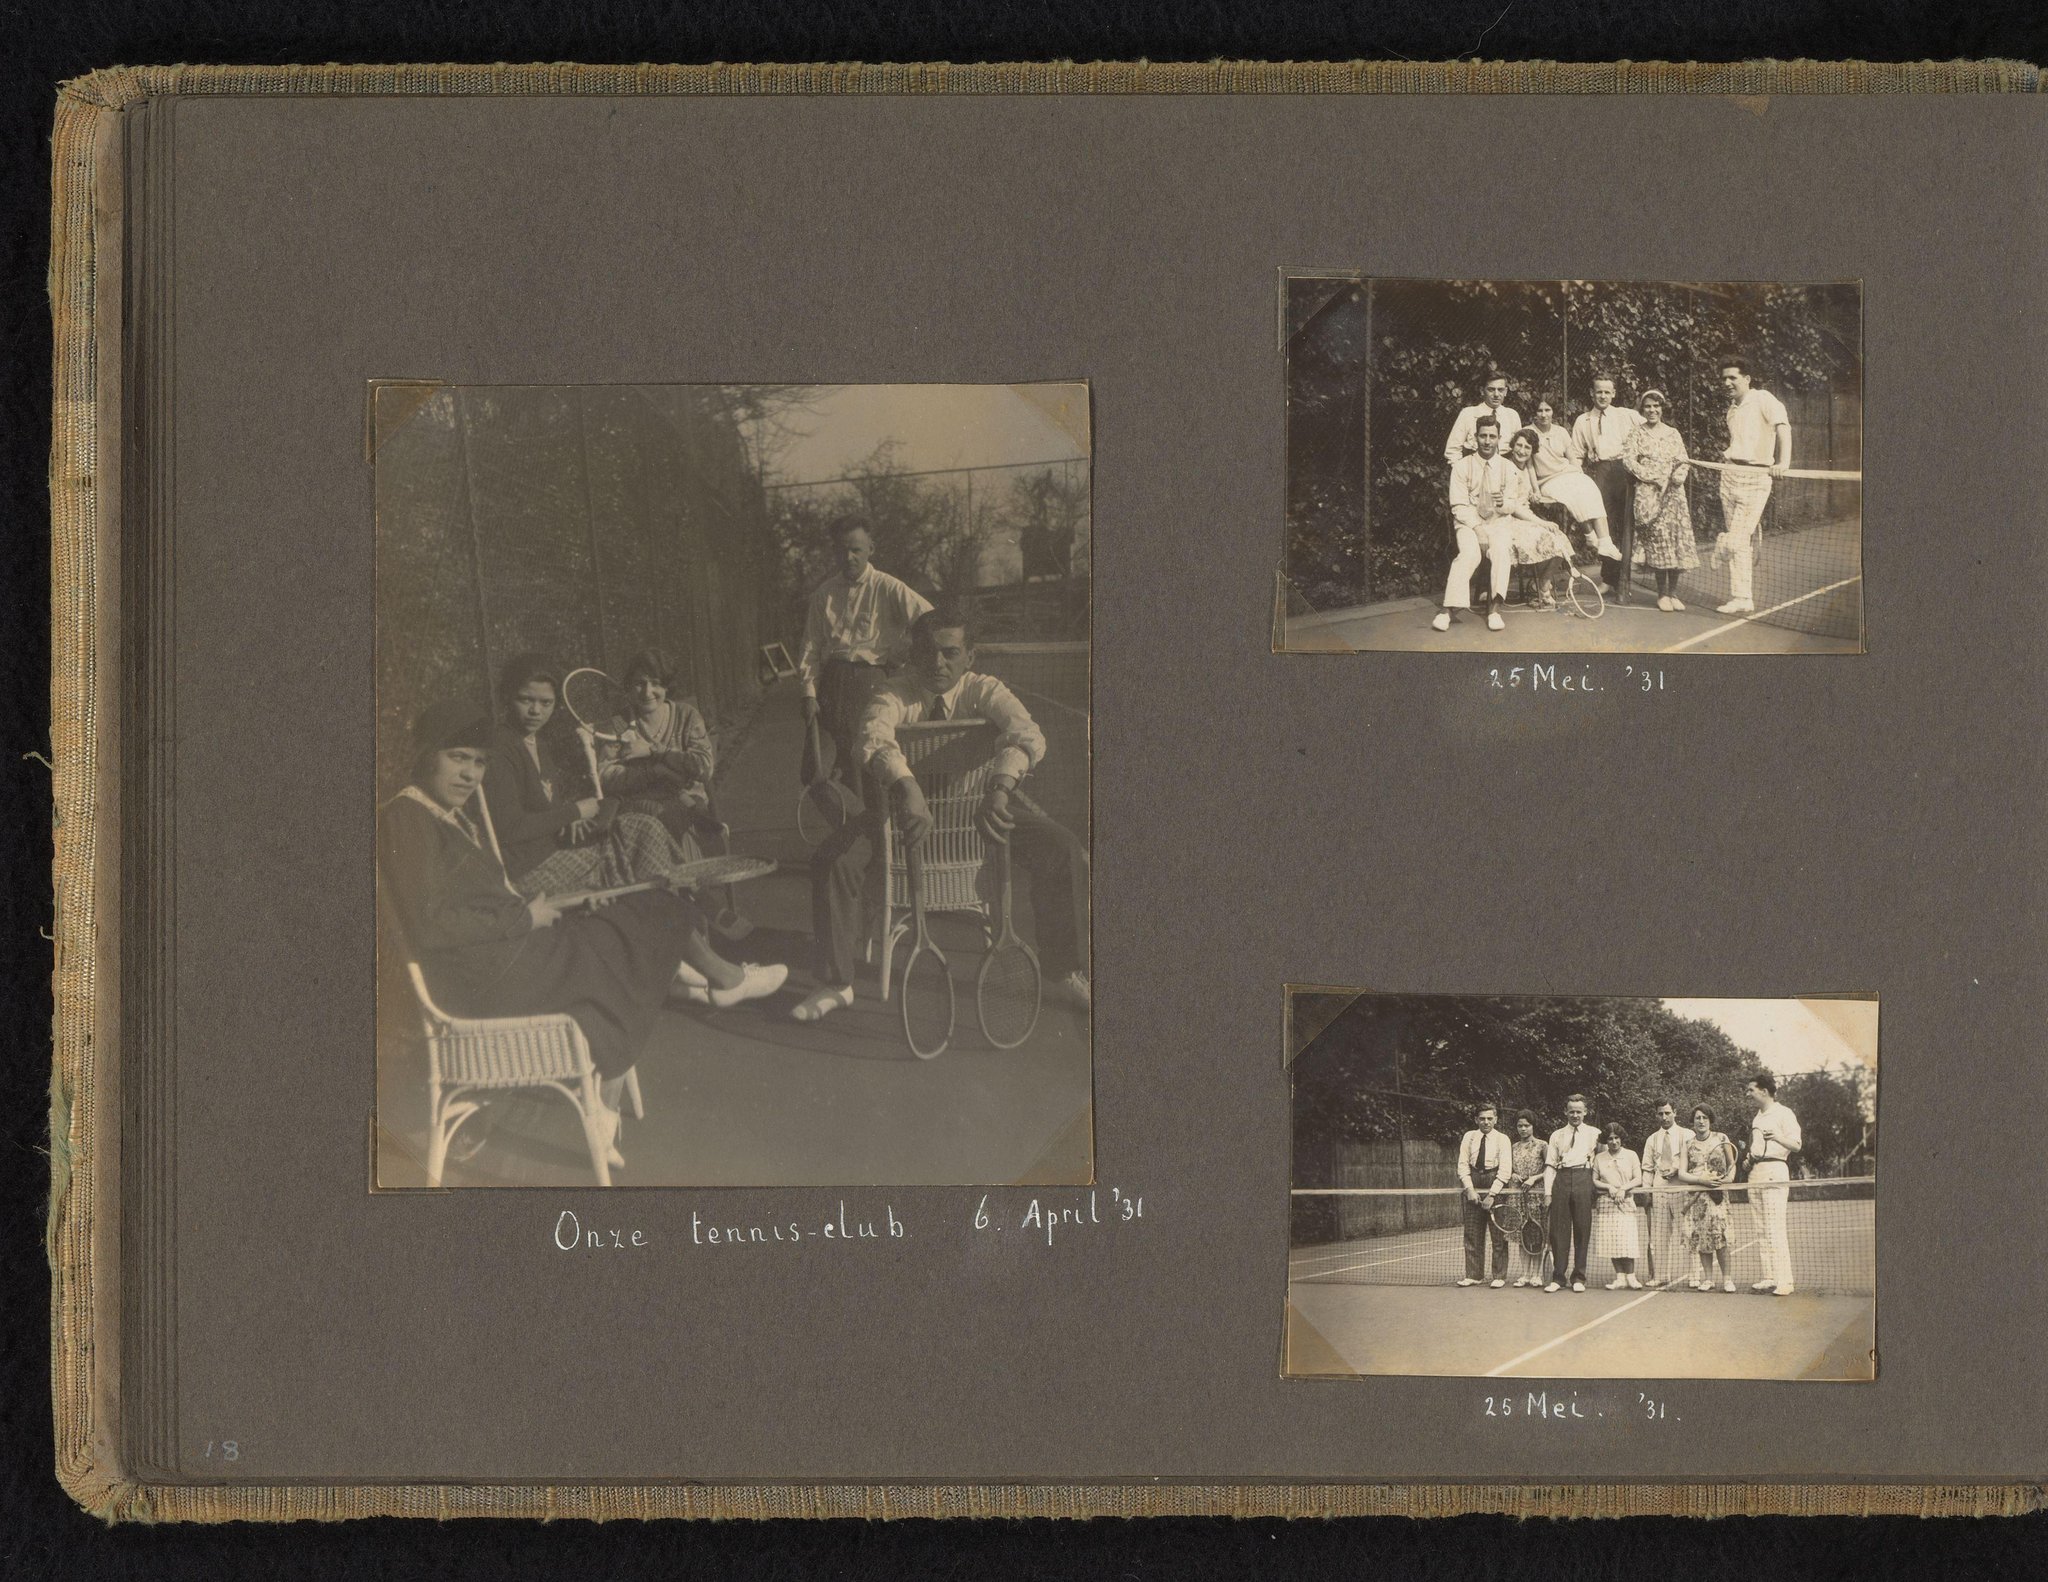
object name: photograph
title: Op de tennisclub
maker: Anonymous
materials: cardboard, photographic support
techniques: gelatin silver print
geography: netherlands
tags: tennis, lawn-tennis, student life, netherlands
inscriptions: inscription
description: Albumblad met drie foto's op de tennisclub, april-mei 1931. Onderdeel van fotoalbum 'Studentenalbum Indologen'.